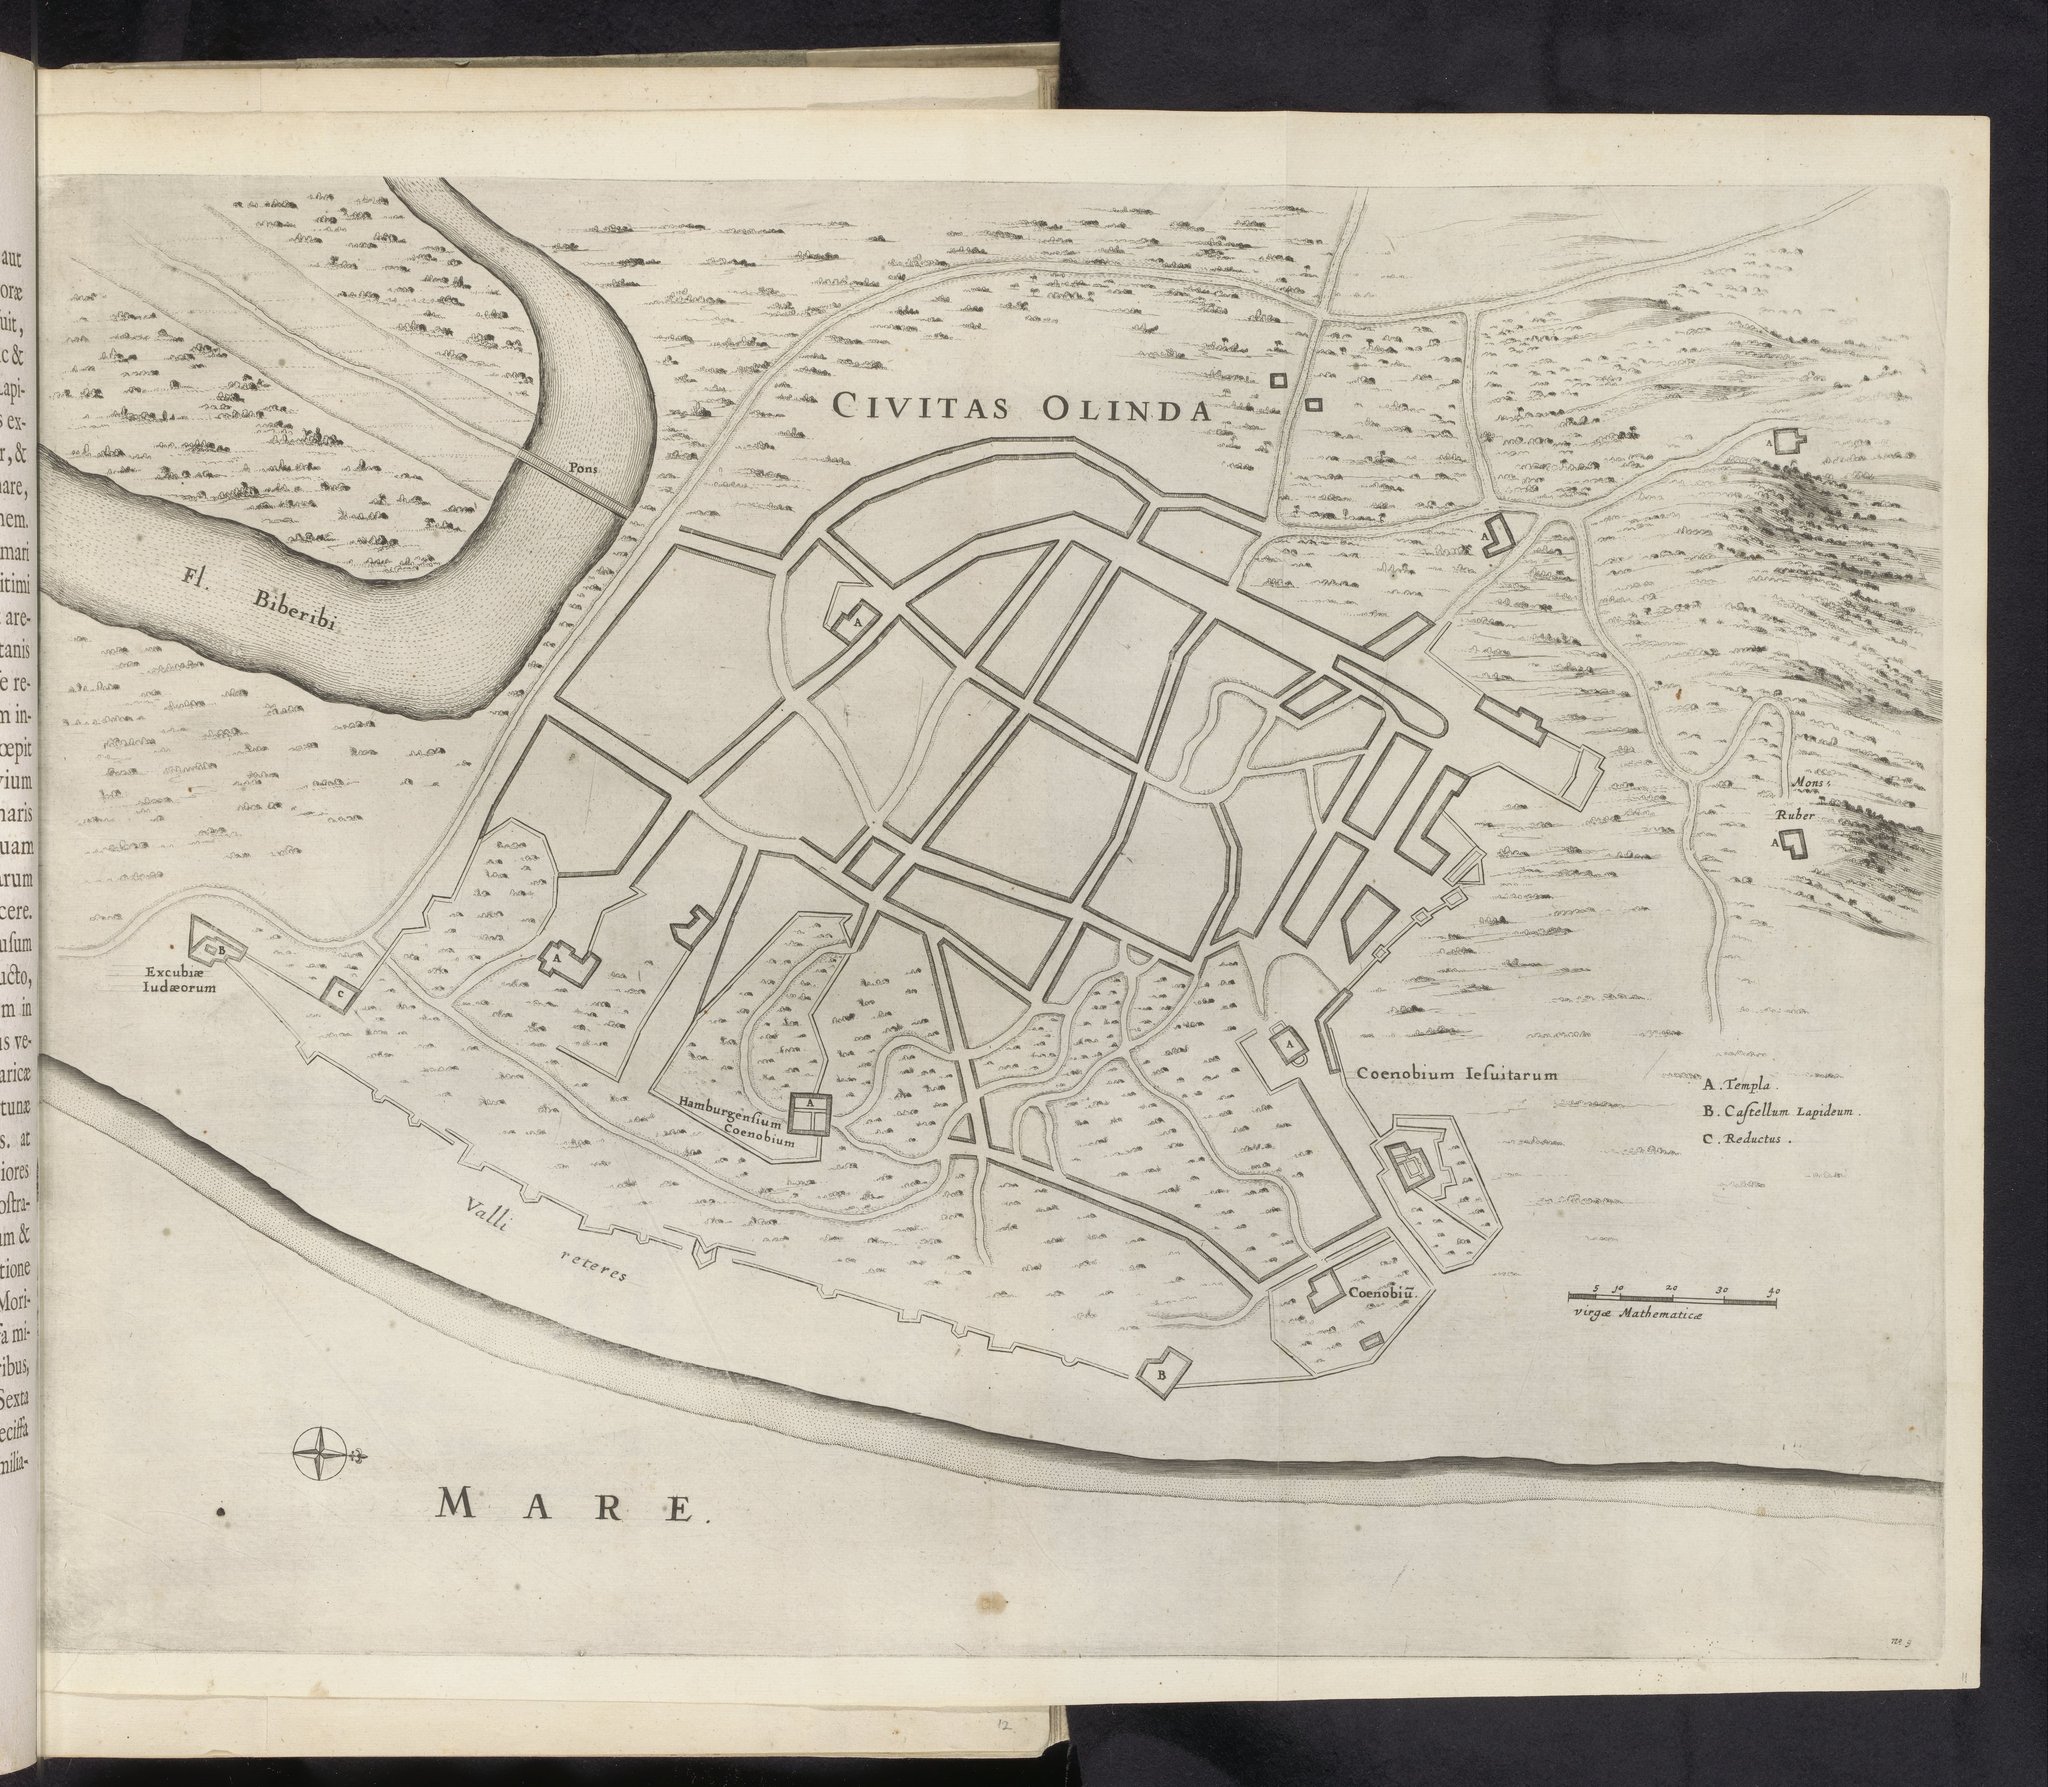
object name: map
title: Civitas Olinda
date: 1645-1647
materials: paper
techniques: engraving, etching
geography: northern netherlands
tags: earl, johan maurits graaf van nassau-siegen, maps of cities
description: Illustratie in: Caspar Barlaeus, Rerum per octennium in Brasilia et alibi nuper gestarum sub praefectura J. Mauritii, Nassoviae, c. comitis... historia, Joannes Blaeu, Amsterdam 1647, plaat nr. 9, p. 40/41. Prent in het exemplaar in de collectie van de Rijksmuseum Research Library, standplaats 330 A 18.